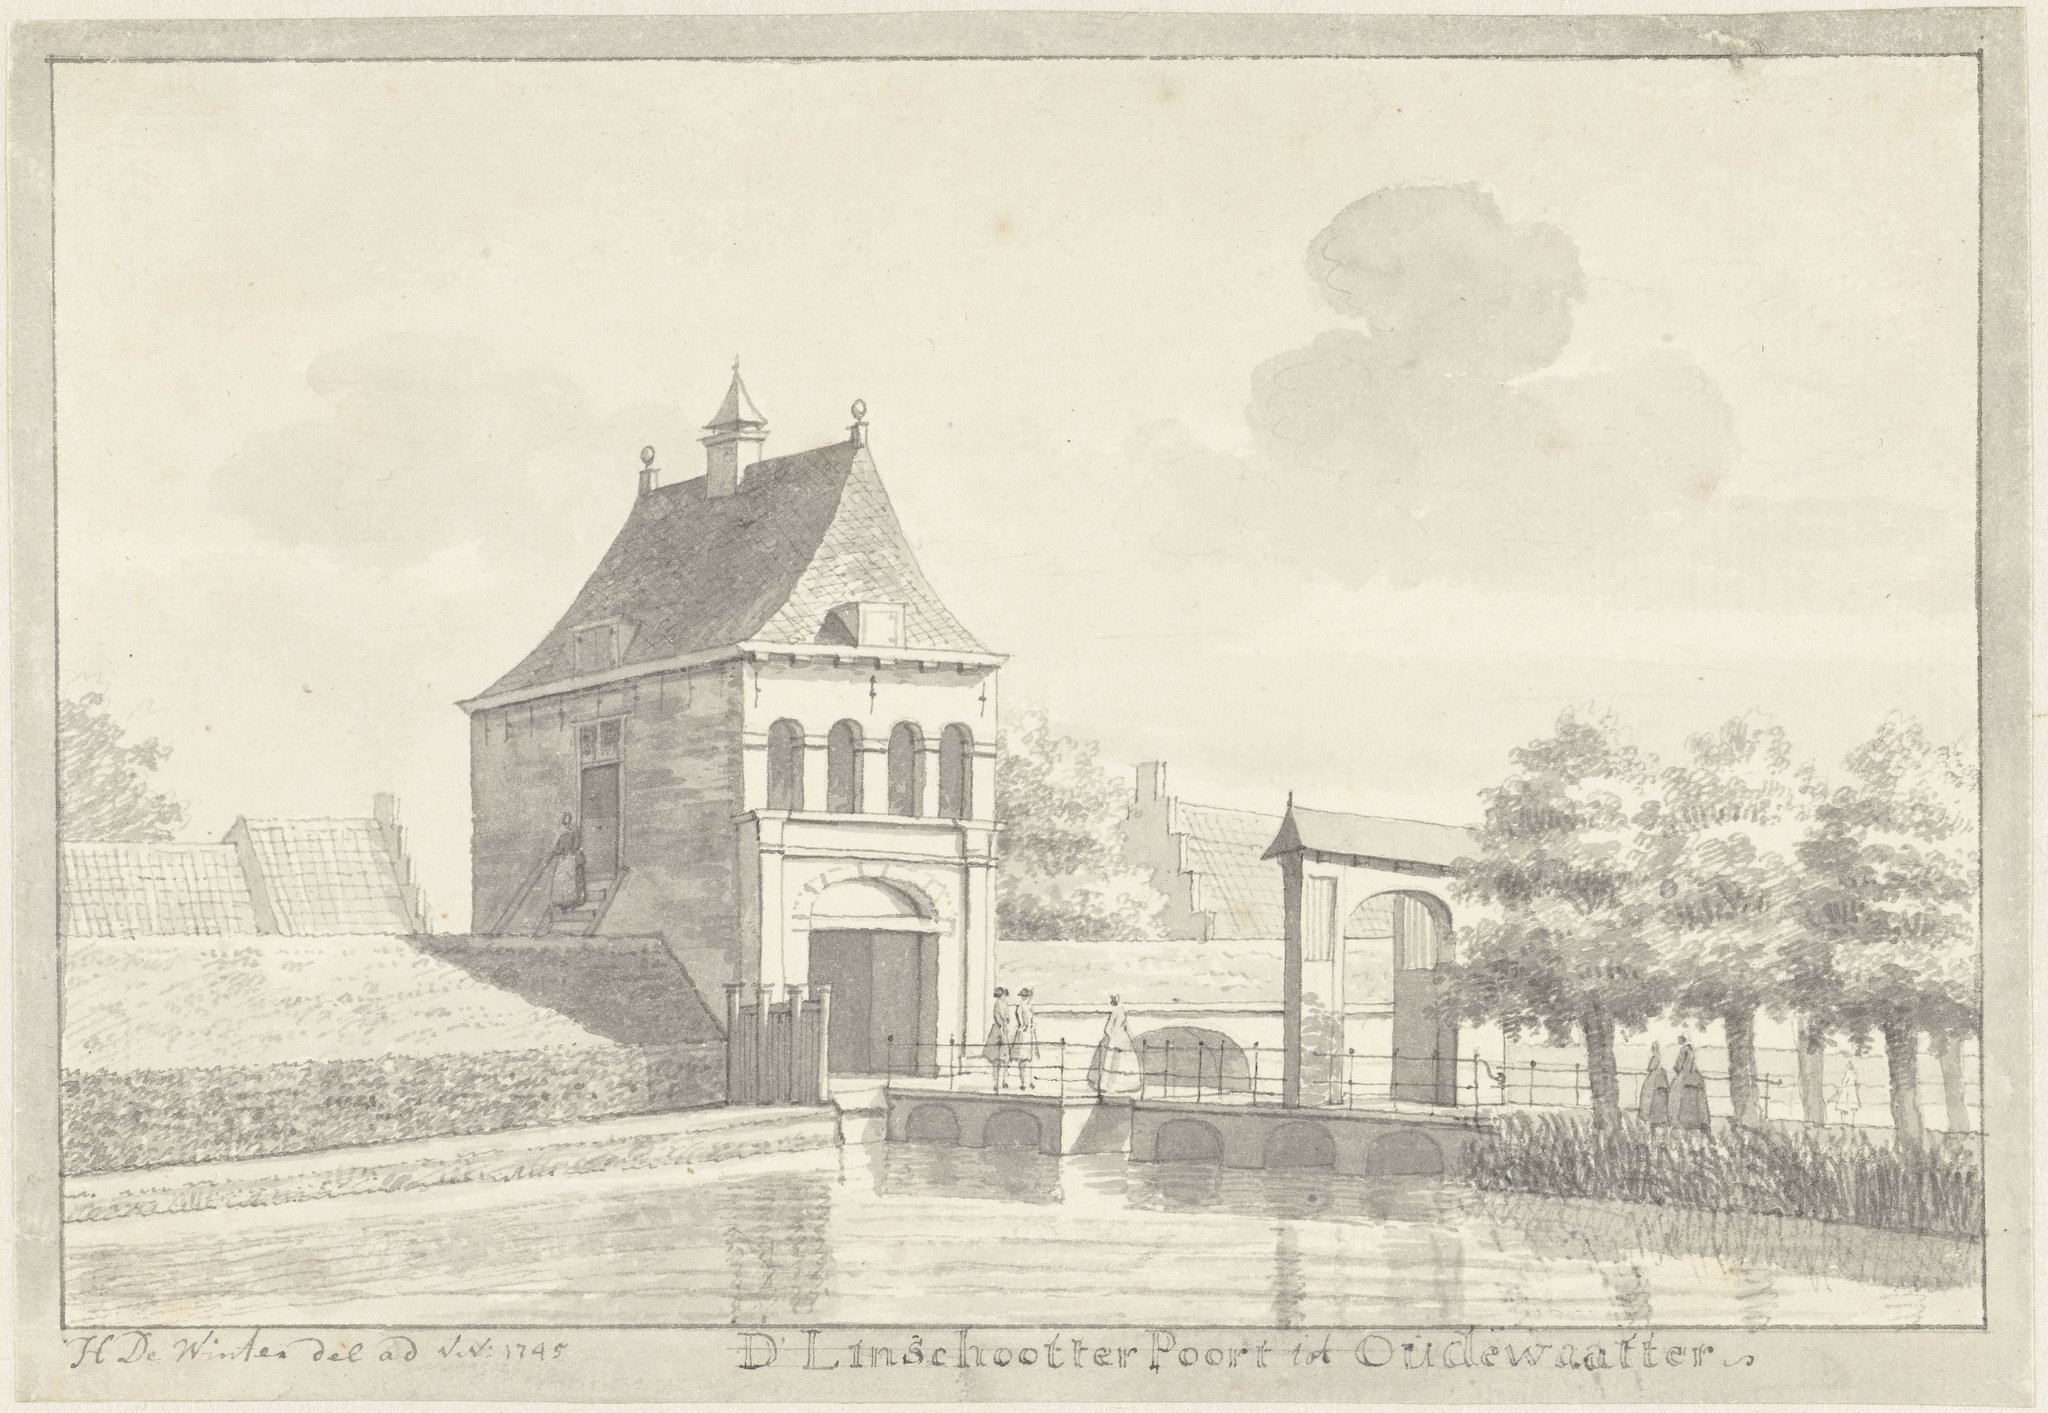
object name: drawing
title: De Linschoterpoort te Oudewater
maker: hendrik de winter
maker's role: draughtsman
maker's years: 1717-1790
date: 1745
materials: ink, paper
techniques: brush, pen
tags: city-walls, bridge, city-gate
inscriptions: inscription: ‘H De Winter del ad viv: 1745 D'Linschootter Poort tot Oudewaatter’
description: Voor prent gebaseerd op deze tekening zie RP-P-AO-10-65A-2.